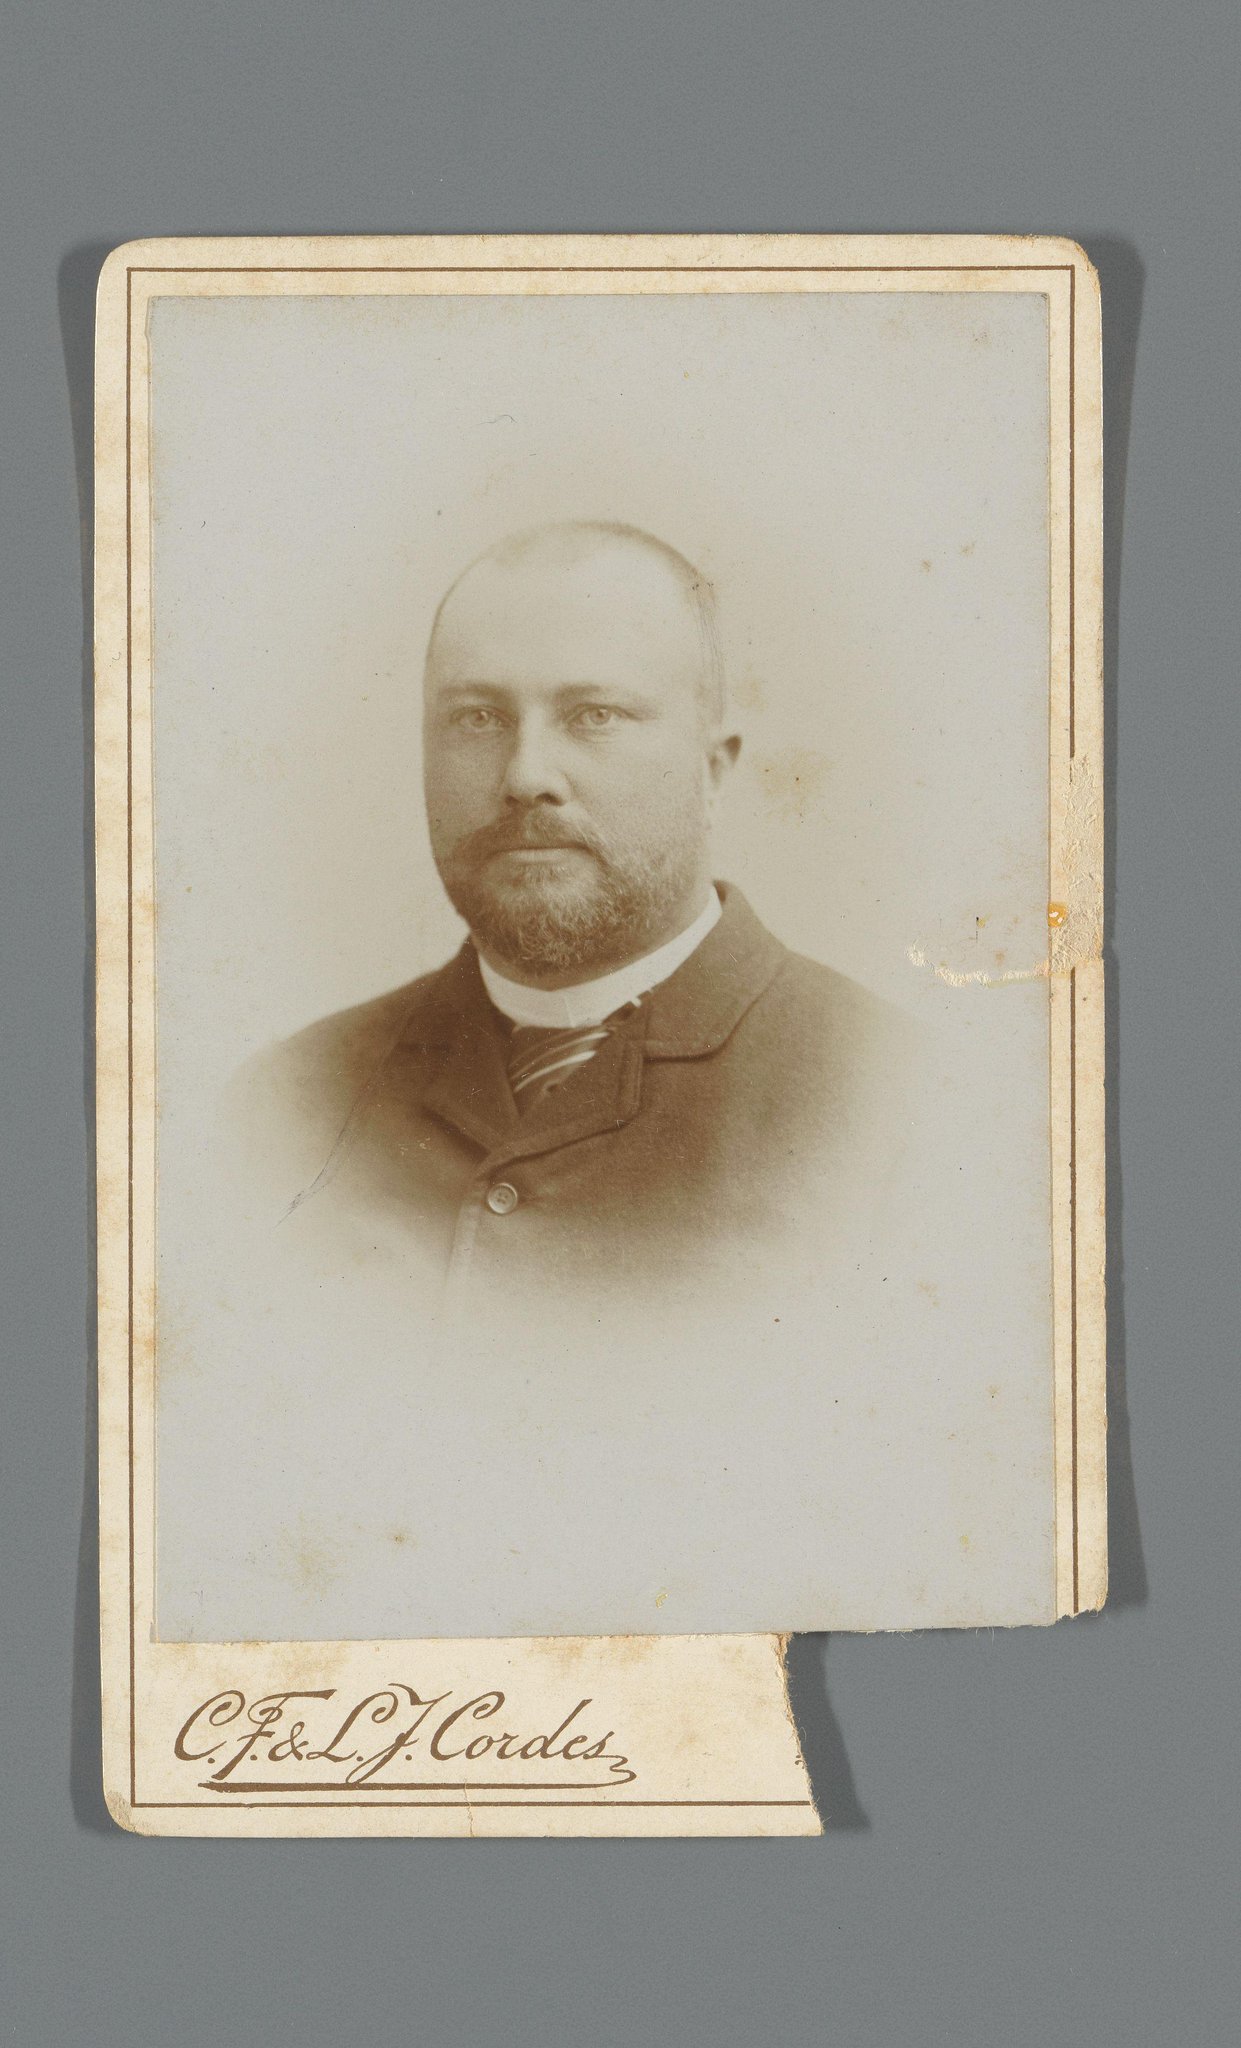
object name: carte de visite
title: Portret van Jhr.ir. Jan Pieter Teding van Berkhout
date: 1880-1904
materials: cardboard, photographic support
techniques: photography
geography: haarlem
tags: historical persons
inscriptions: annotation: ‘J. Piet TvB (broer van Jet Go Jo Frederik halfbroer Hendrik Suze Frans)’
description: Portret van Jhr.ir. Jan Pieter Teding van Berkhout, halfbroer van Hendrik Jr.